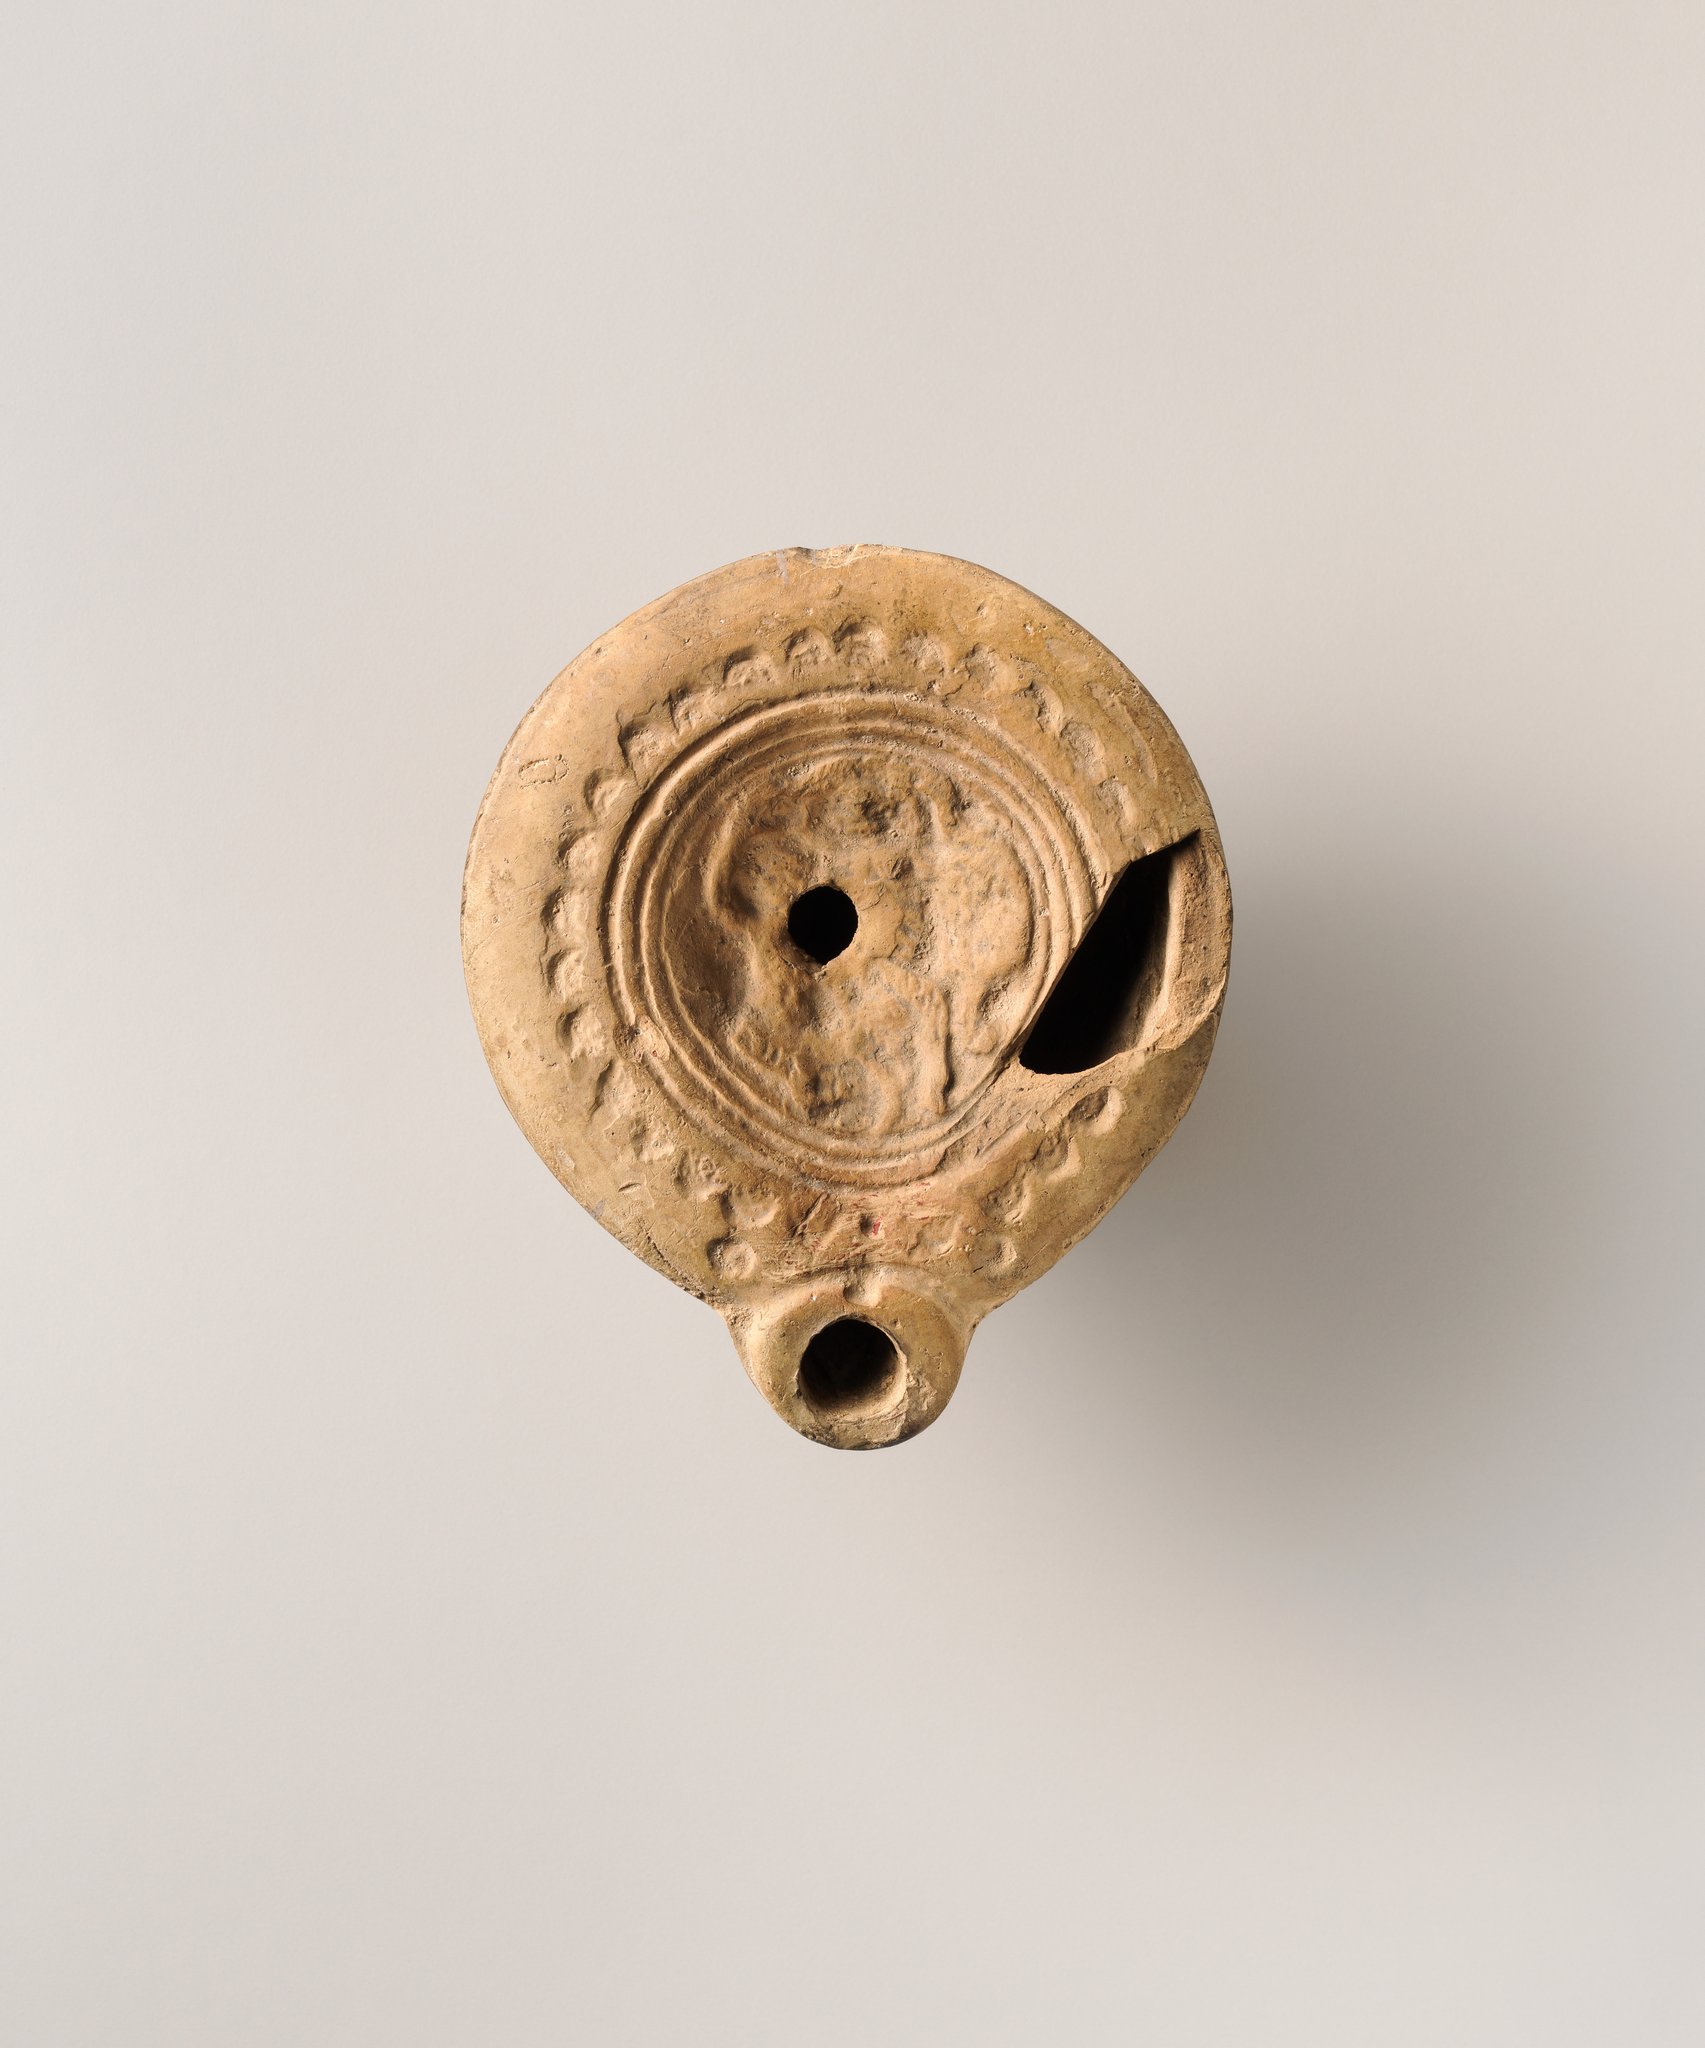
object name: lamp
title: Terracotta oil lamp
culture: roman, syrian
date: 101-300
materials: terracotta